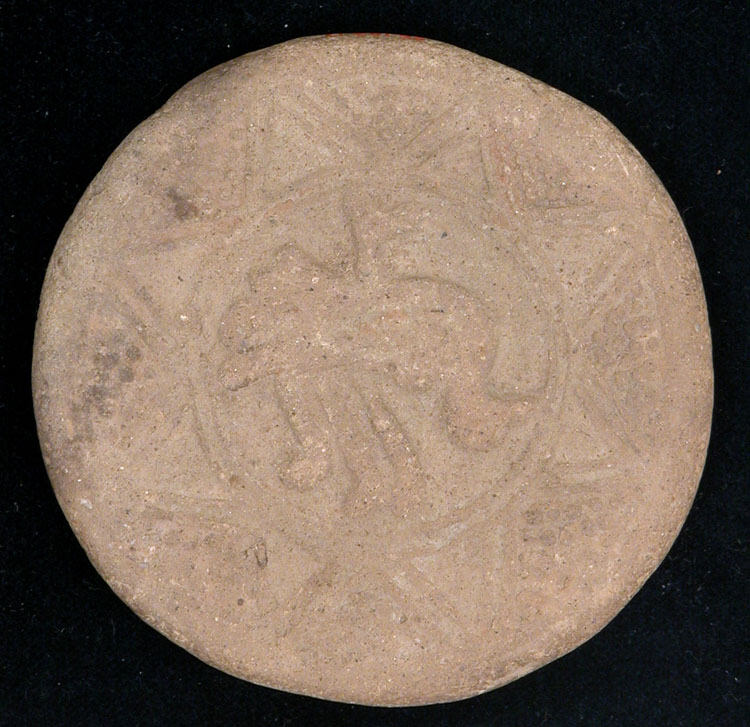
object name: bath scraper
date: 1101-1300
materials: earthenware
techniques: molding, relief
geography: iran